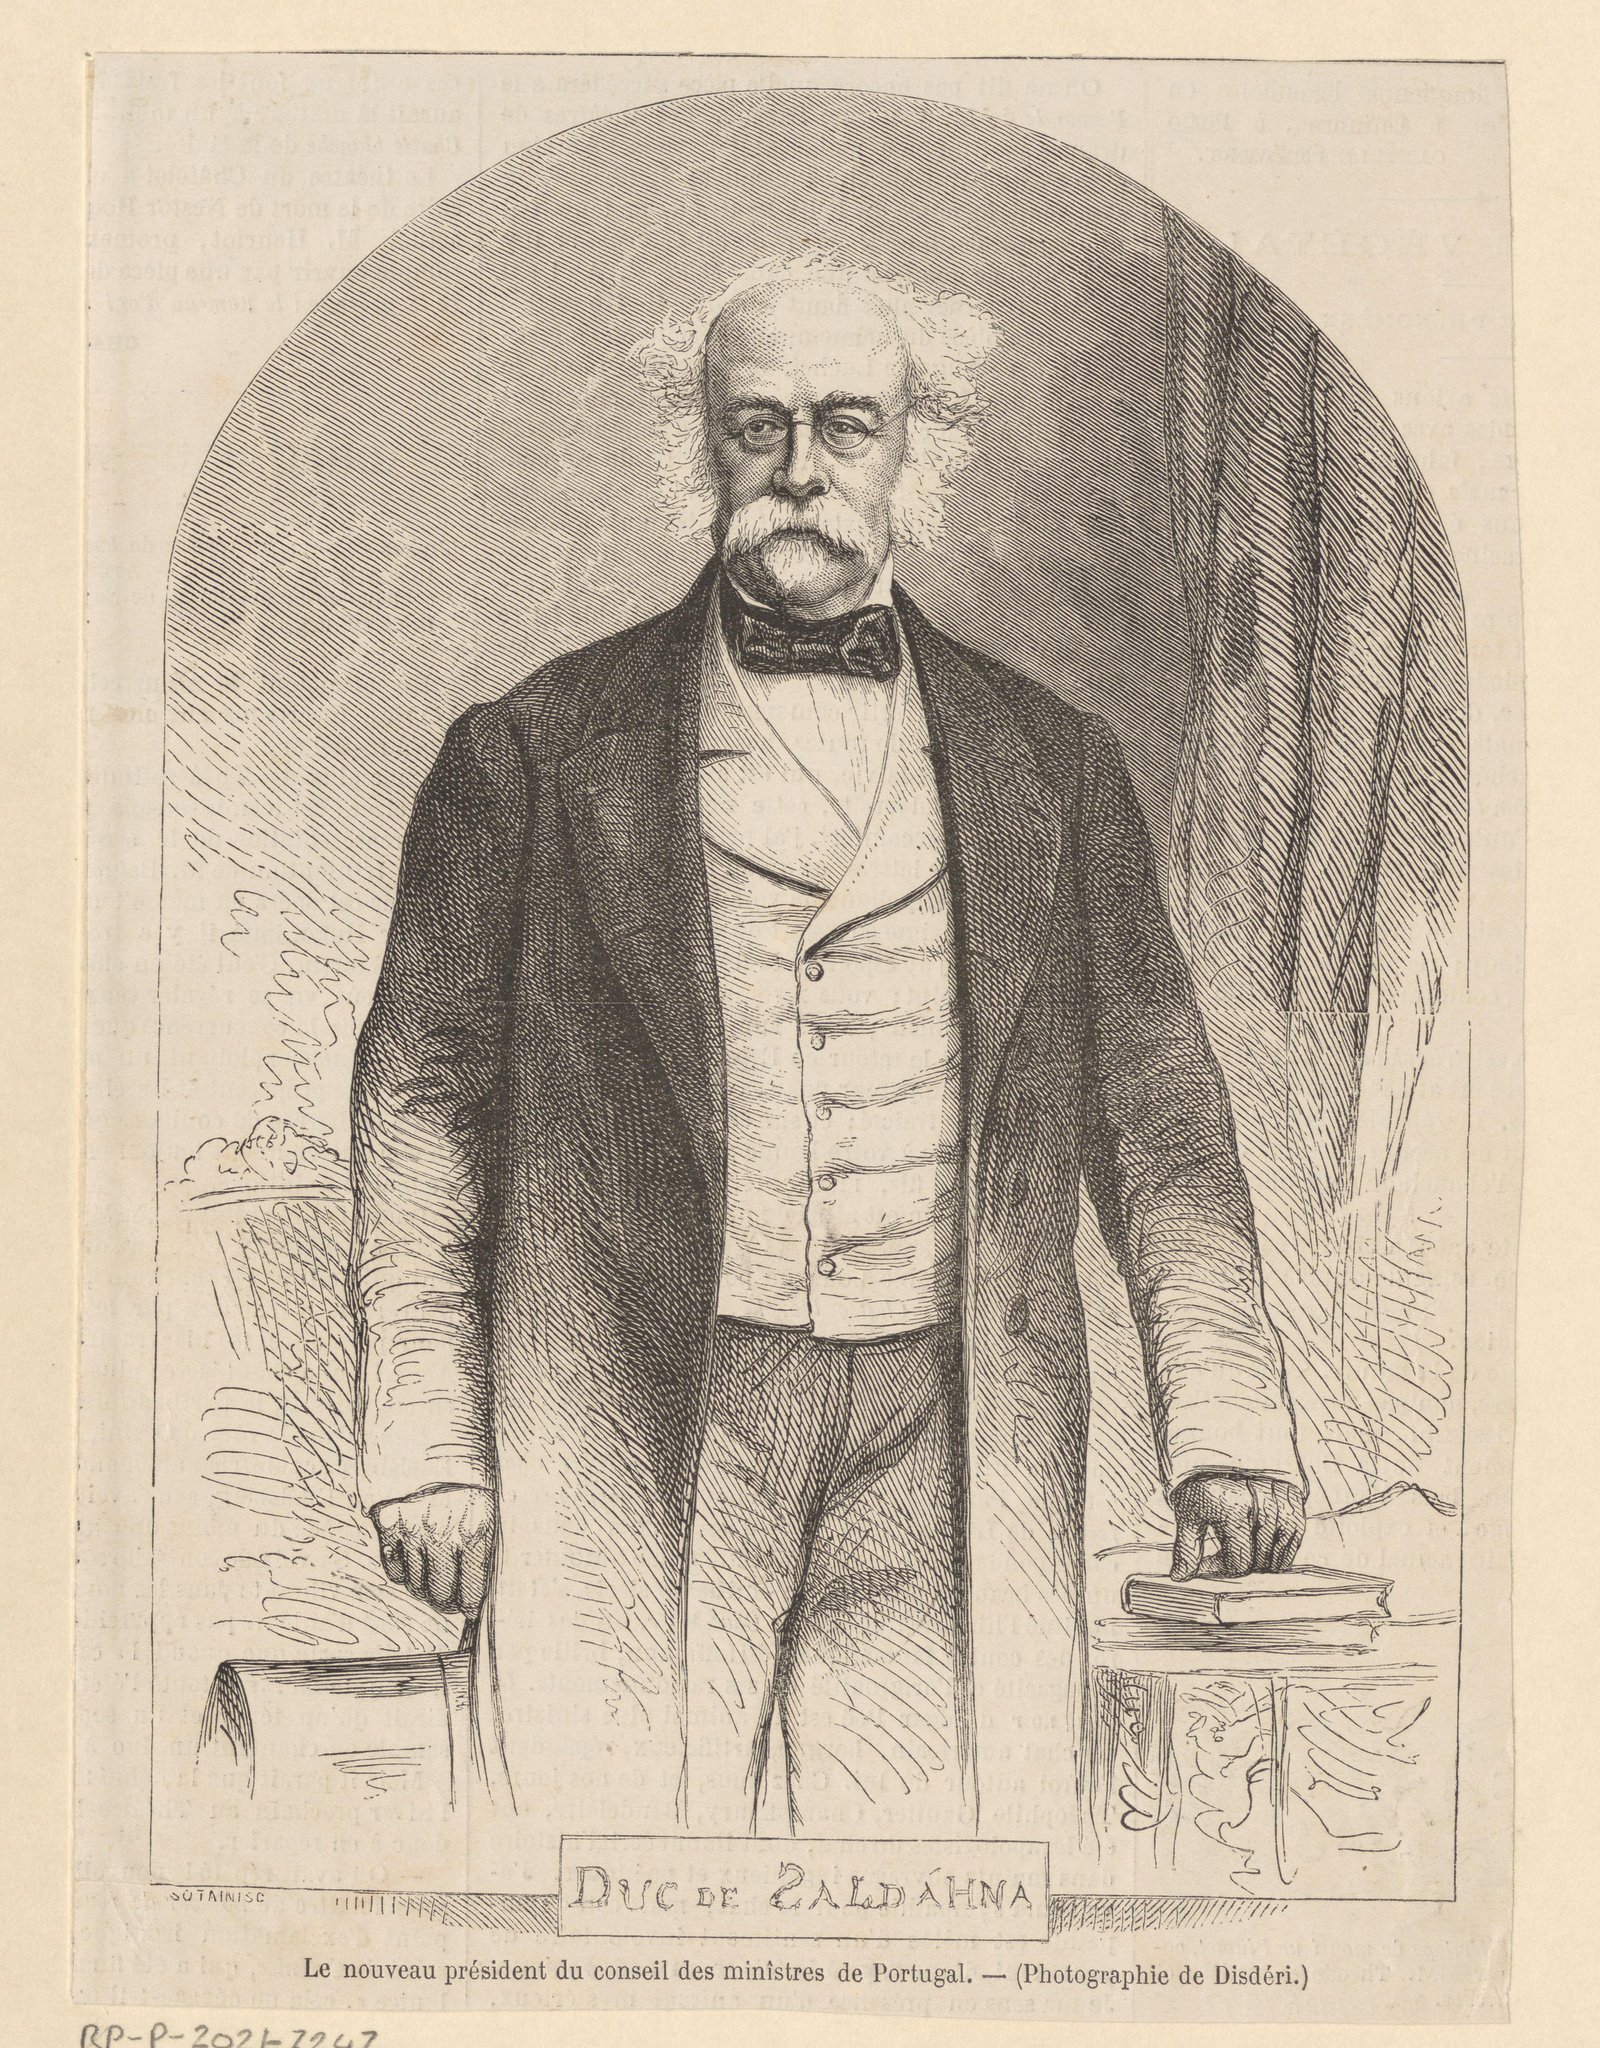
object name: print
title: Portret van João Carlos Saldanha de Oliveira Daun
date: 1870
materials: paper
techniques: letterpress printing, engraving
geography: paris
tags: politician, president ~ head of republic, historical persons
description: Prent uit: Le Monde Illustré 14 (1870), nr. 685, 28 mei 1870.